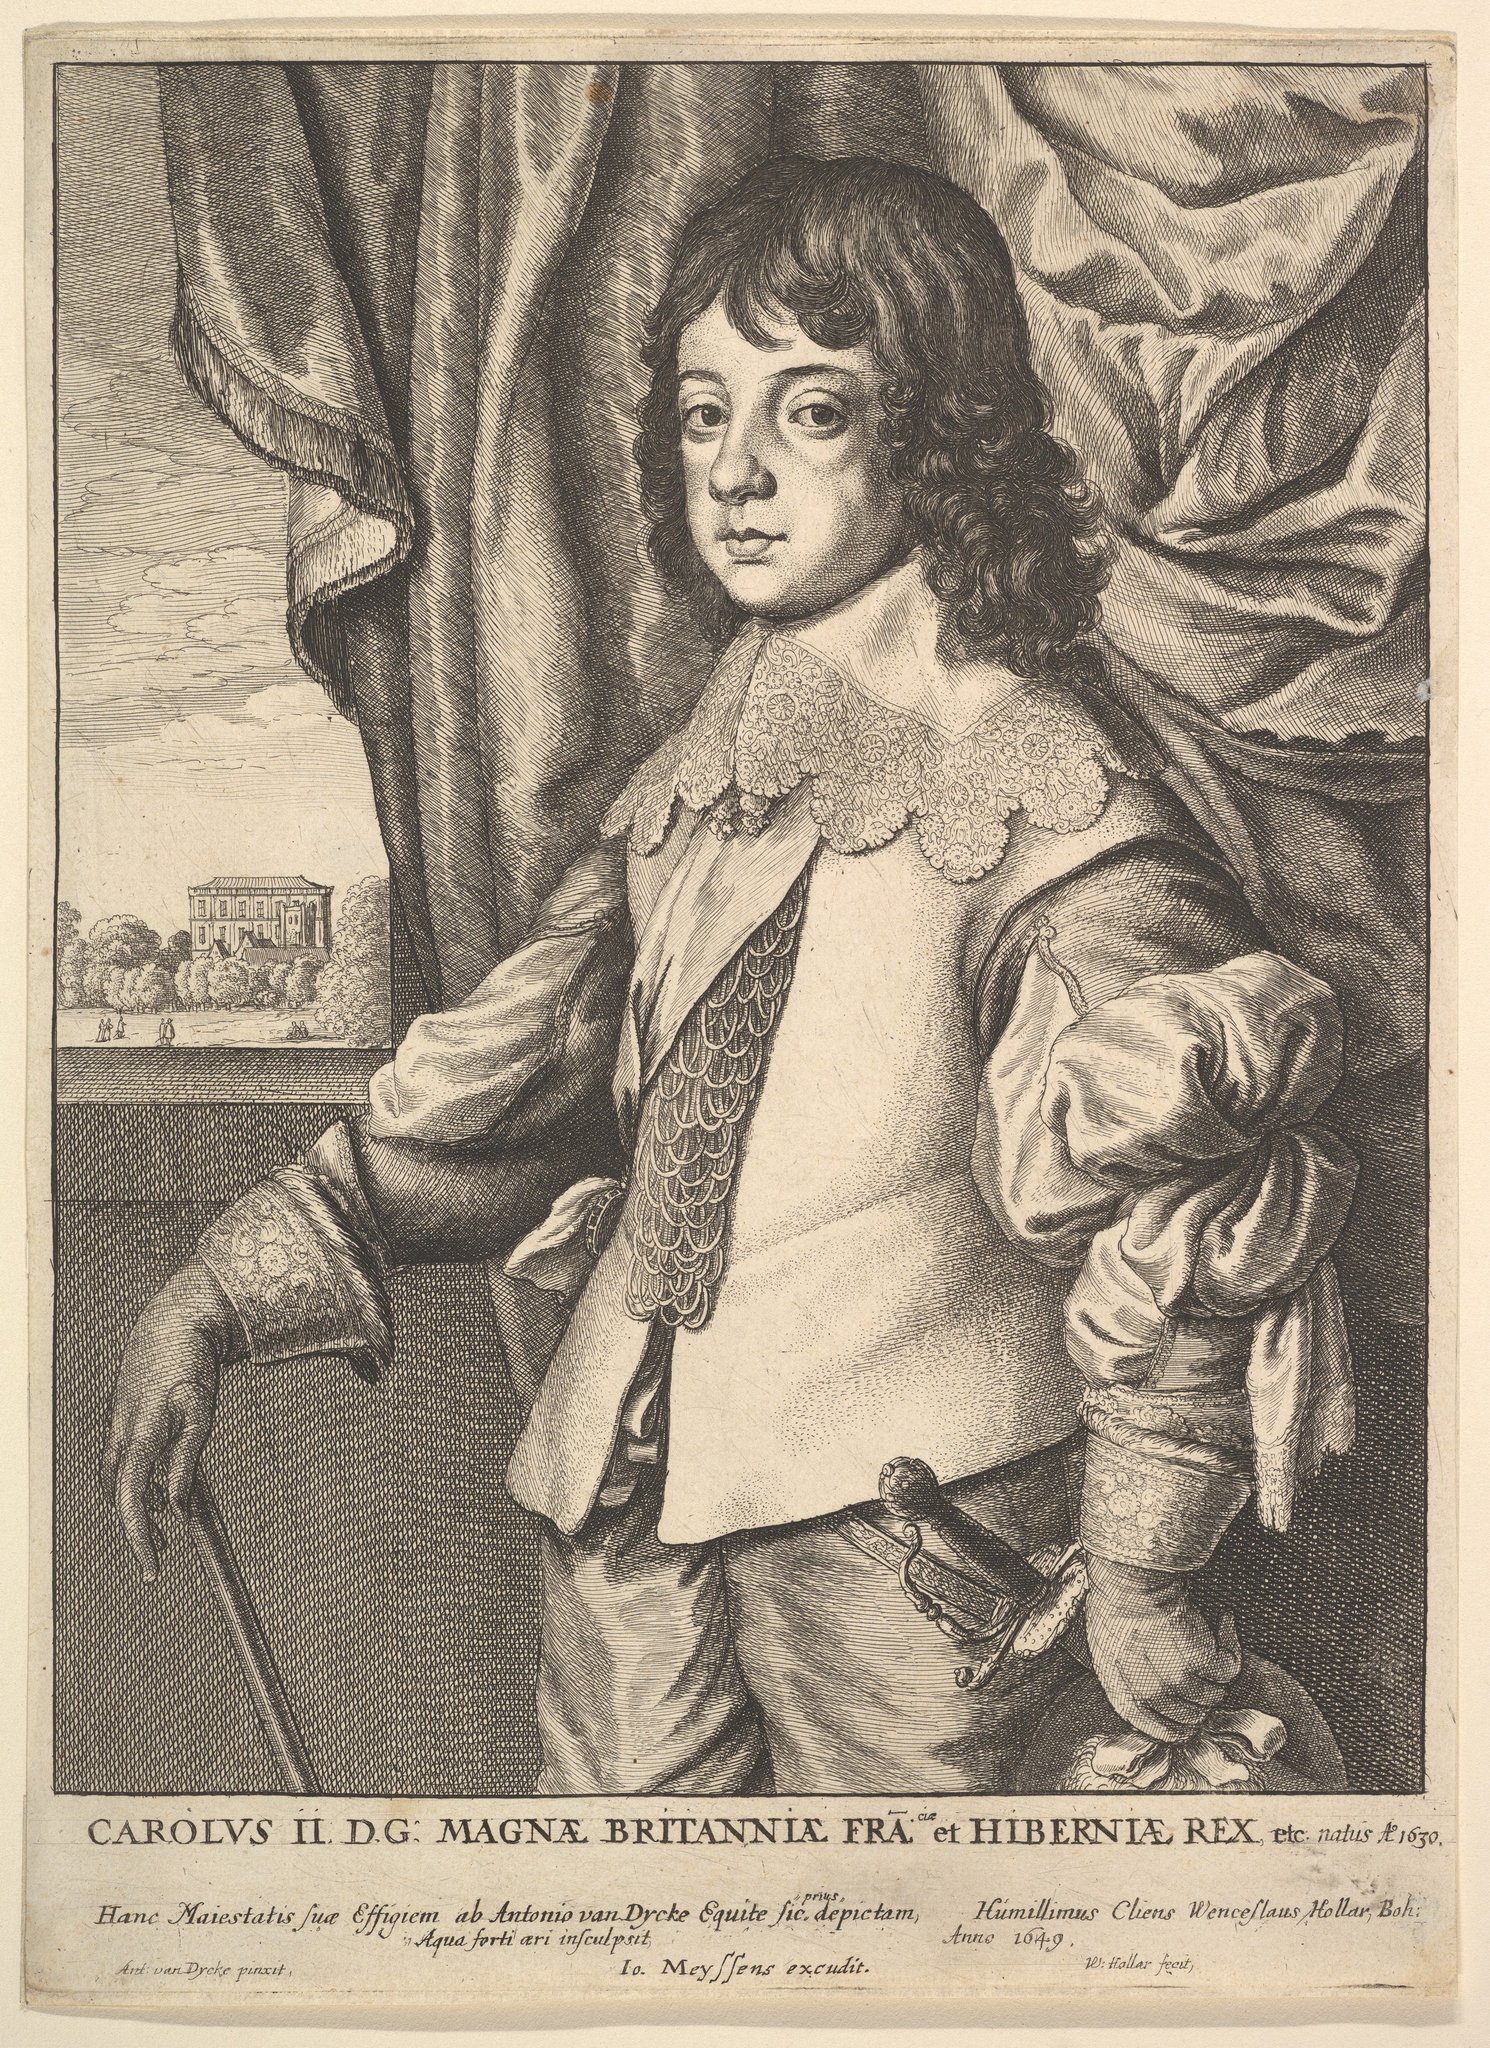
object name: print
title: Charles II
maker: wenceslaus hollar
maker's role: artist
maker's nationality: bohemian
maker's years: 1607-1677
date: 1649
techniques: etching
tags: boys,portraits